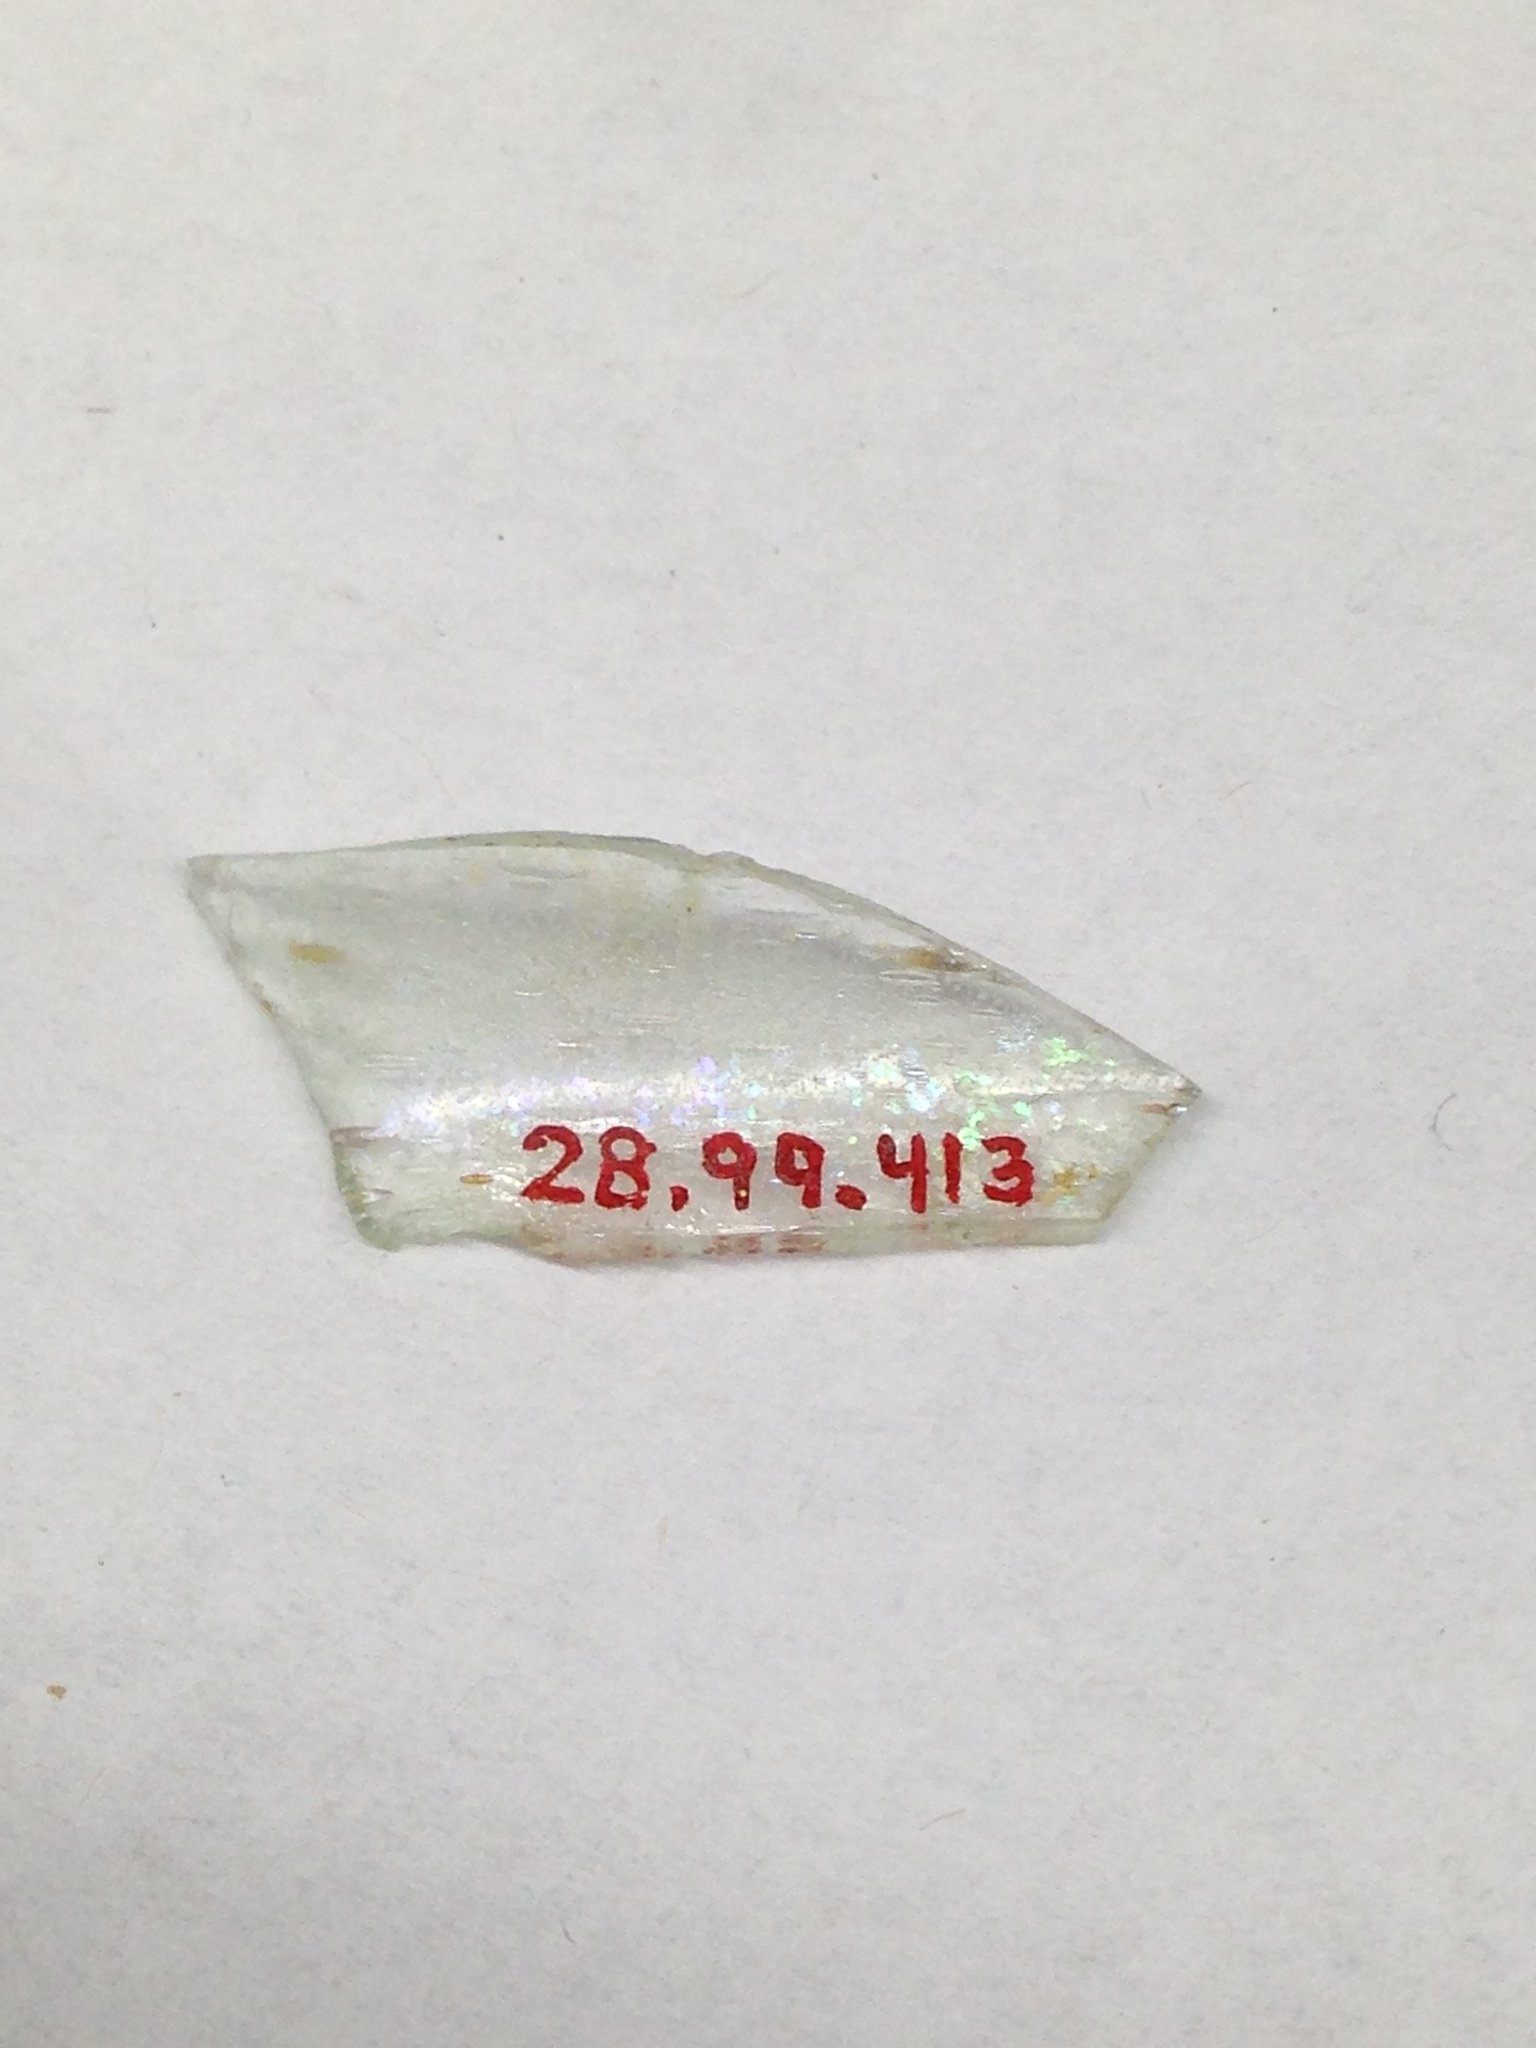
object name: fragment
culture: european or middle eastern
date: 1150-1250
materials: ceramic, glass